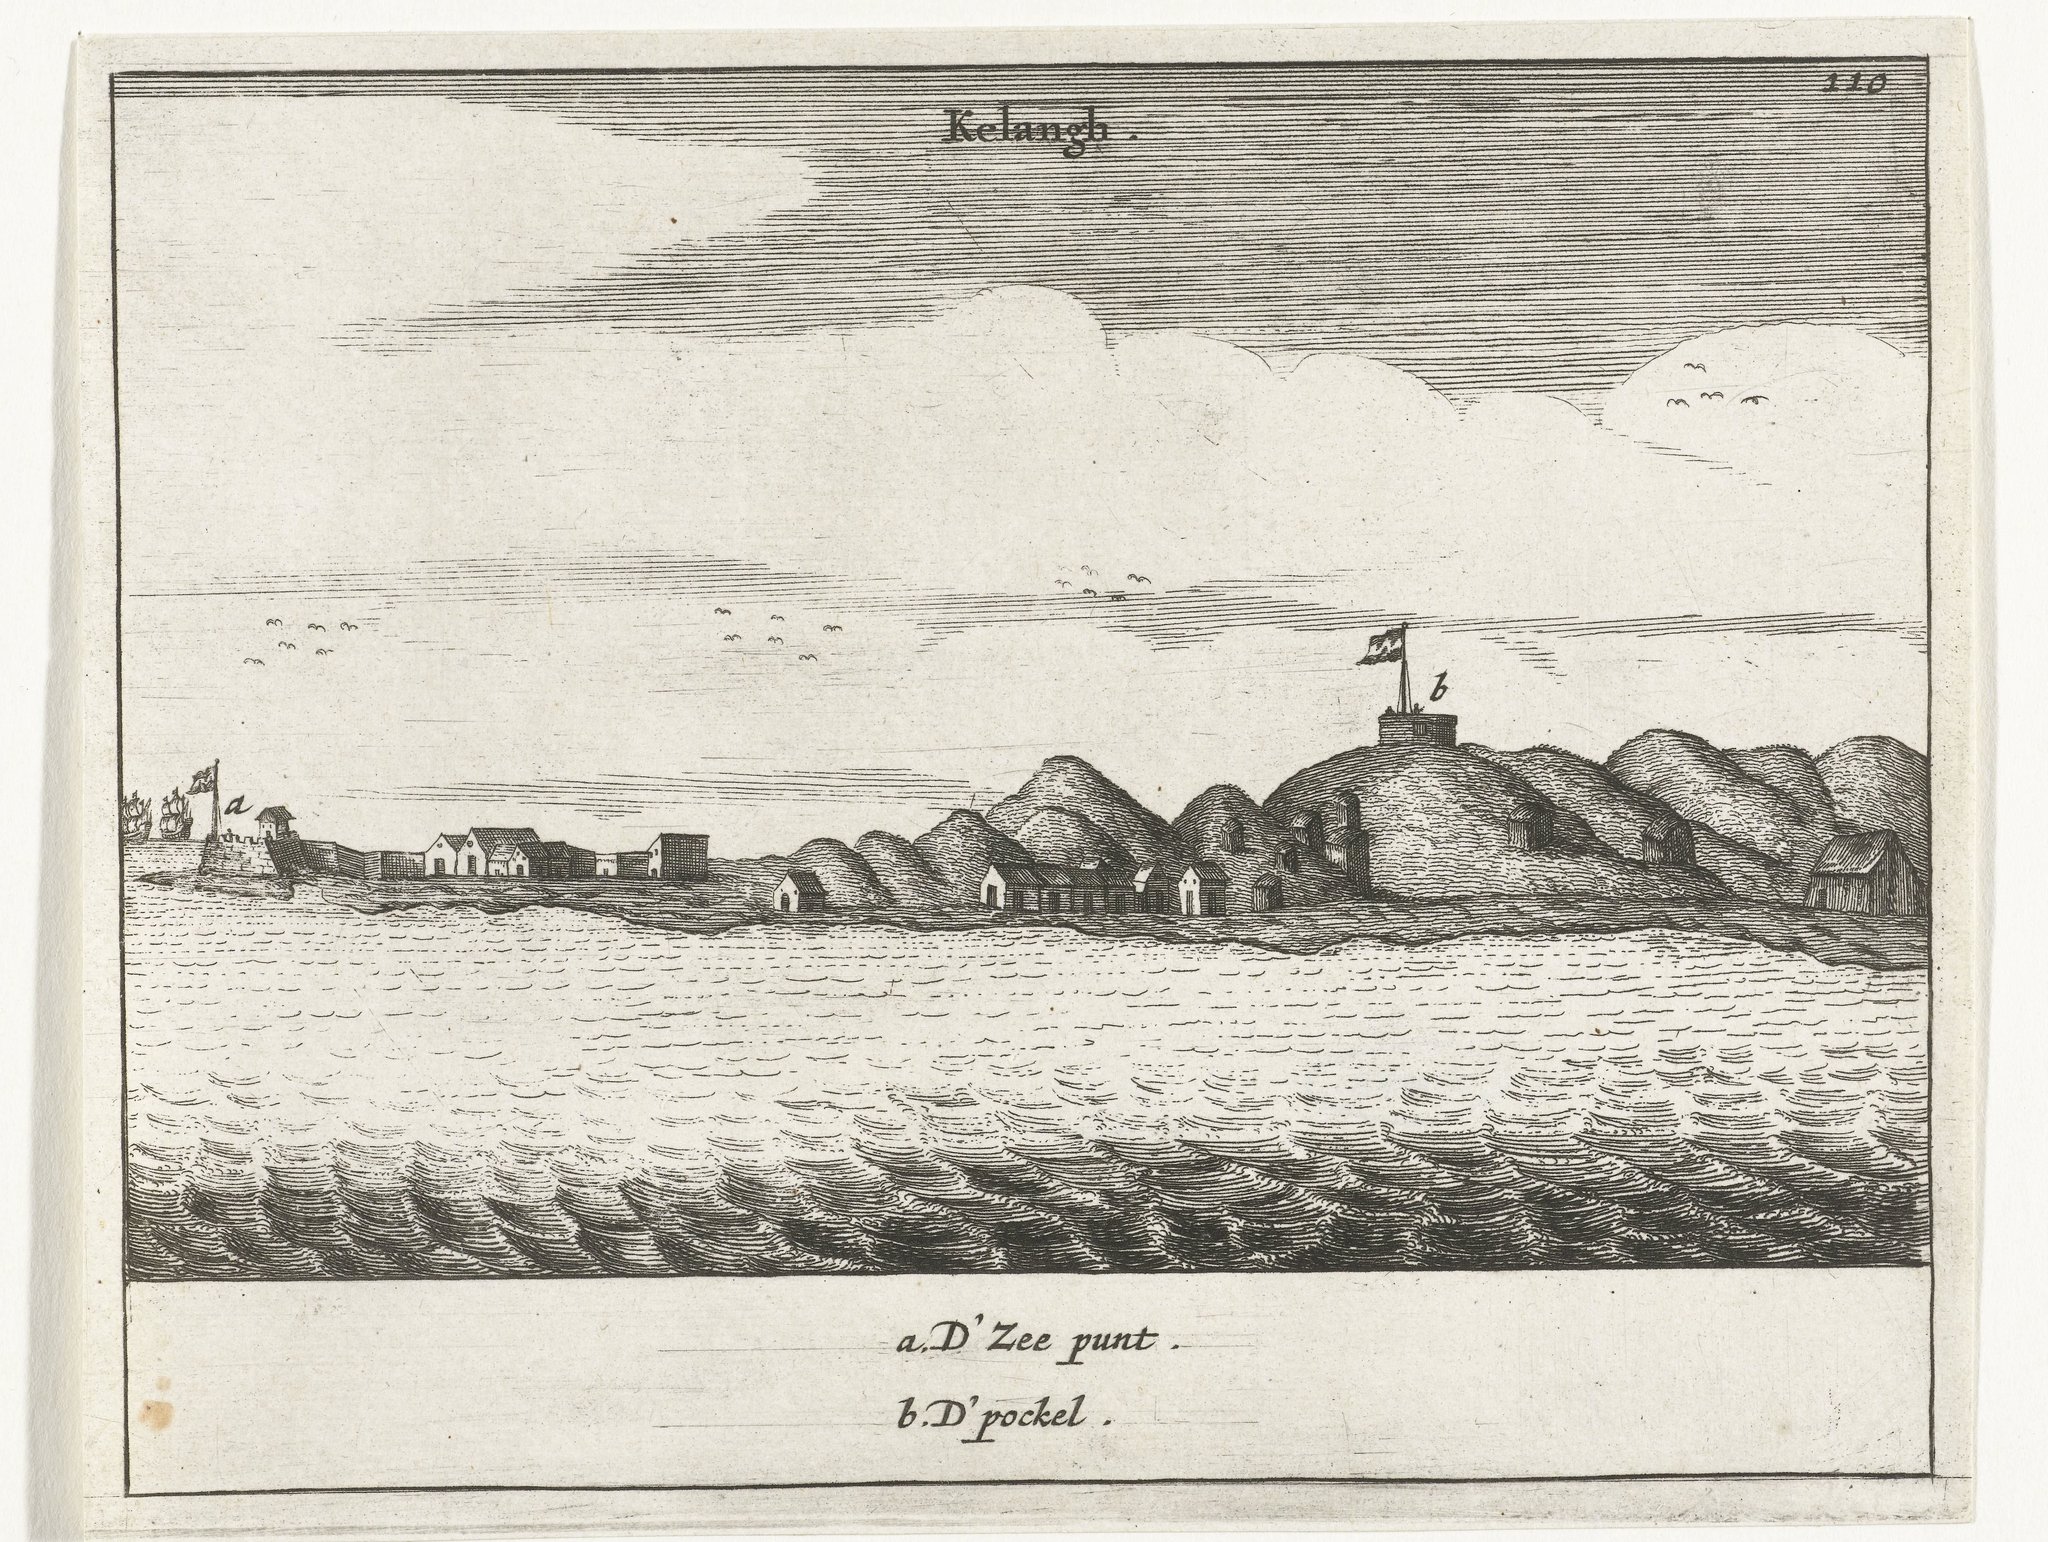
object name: print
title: Gezicht op Kelangh (Formosa), 1664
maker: Anonymous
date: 1670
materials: paper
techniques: etching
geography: northern netherlands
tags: japan, sailing-ship, sailing-boat, formosa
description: Gezicht op de Nederlandse vestiging Kelangh (Chi-lung op Formosa), september 1664. In verband met de expedities van de VOC van 1662-1665 onder leiding van Balthasar Bort tegen de Chinese krijgsheer Coxinga. In het onderschrift de legenda a-b. Gemerkt rechtsboven: 110.